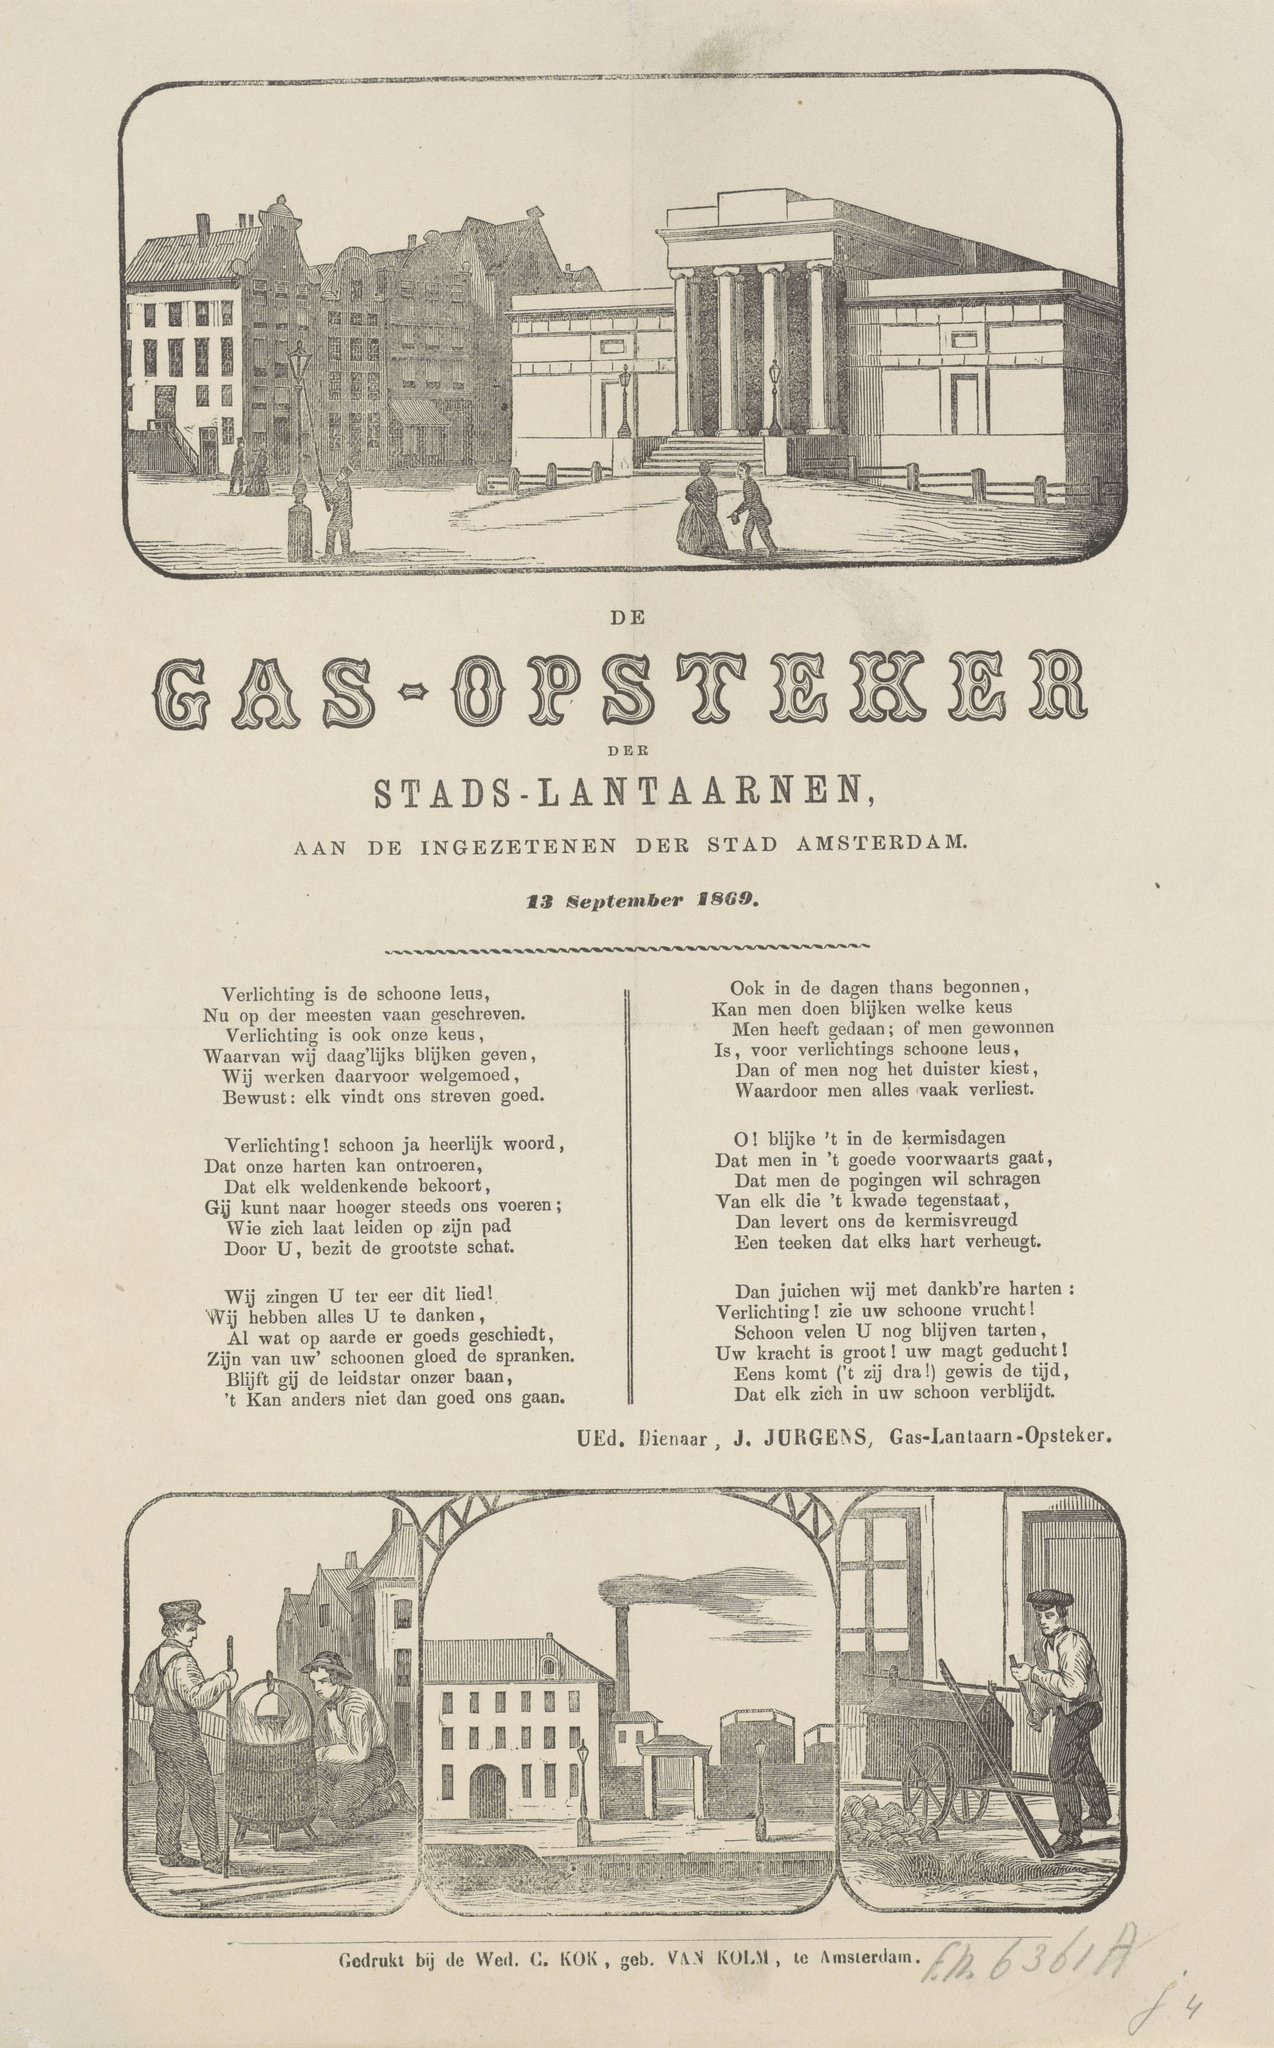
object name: fair print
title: Kermisprent van de gaslantaarnopstekers van Amsterdam voor het jaar 1869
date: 1869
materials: paper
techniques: letterpress printing, engraving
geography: amsterdam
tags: gas-lamp (+ kindling a light; lit, burning light, lamp, candle), gas supply, street lighting, street, amsterdam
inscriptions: collector's mark: Lugt 2228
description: Kermisprent van de Amsterdamse gaslantaarnopstekers, 13 september 1869. Centraal een vers in twee kolommen. Bovenaan de Dam met de beurs van Zocher te Amsterdam. Onderaan de Hollandsche Gasfabriek en twee gasfitters aan het werk. Van de gaslantaarnopsteker: J. Jurgens.